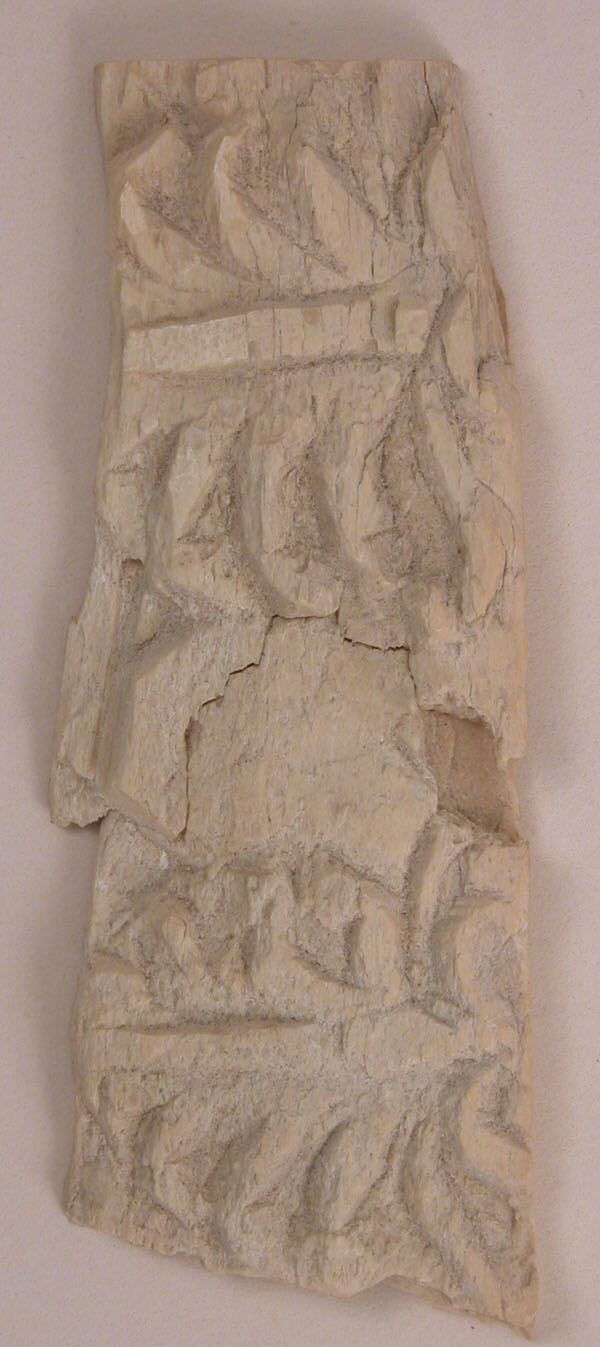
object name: plaque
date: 401-800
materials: bone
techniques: carving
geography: palestine